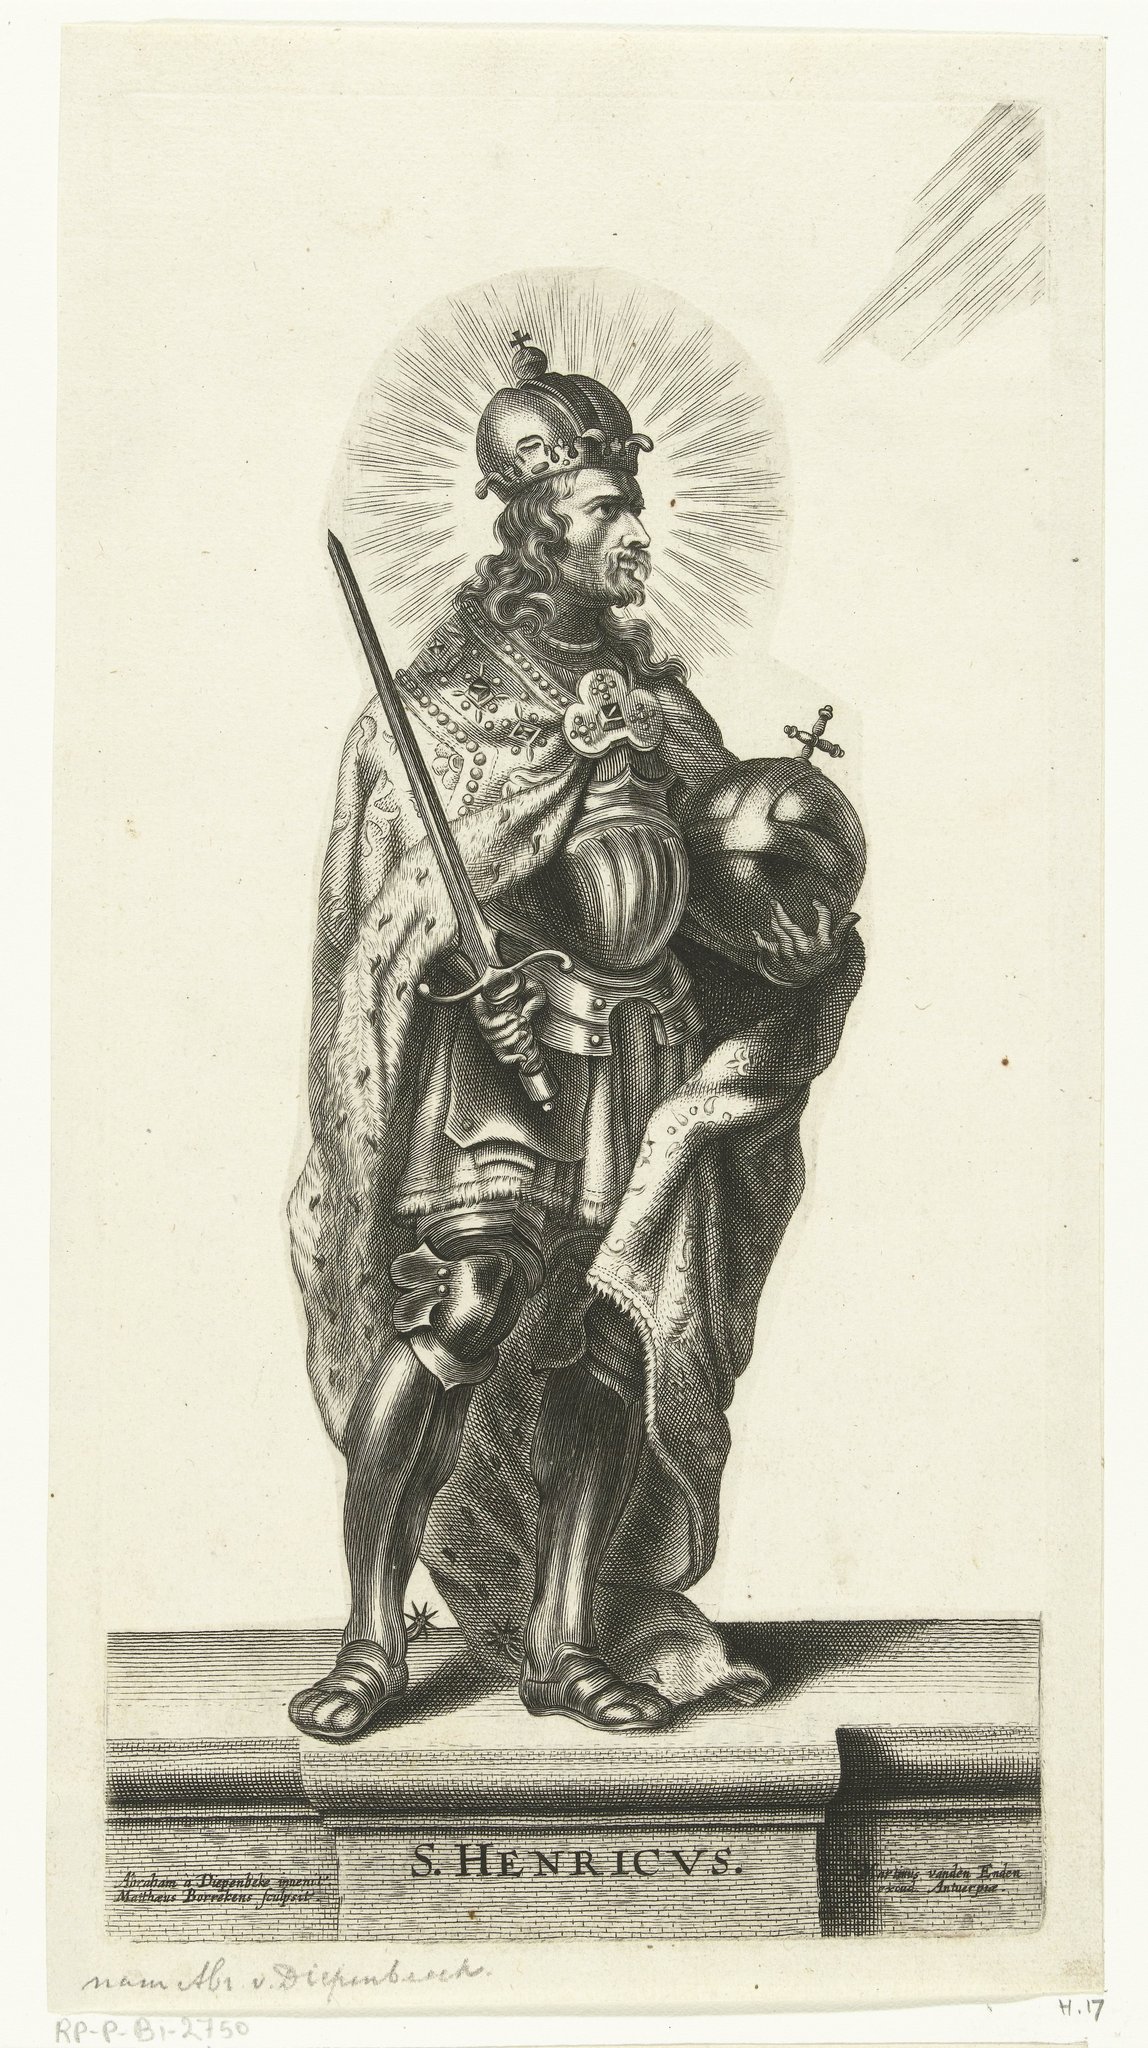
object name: print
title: S. Henricus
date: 1644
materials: paper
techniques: engraving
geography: antwerp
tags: the holy roman emperor henry ii of bamberg; possible attributes: crown, lily, model of church, orb, sceptre, sword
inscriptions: collector's mark: Lugt 240 of 1838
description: De Heilige koning Hendrik II van Duitsland en keizer van het Heilig Roomse rijk. Hendrik draagt een wapenrusting en zijn keizersmantel. Hij draagt tevens de keizerskroon. In zijn linkerhand houdt hij de wereldbol (met kruis) vast, teken van zijn rol als keizer. In zijn rechterhand heeft hij een zwaard, symbool van zijn wereldlijke gezag. Hij heeft een aureool rond zijn hoofd en kijkt naar de rechterbovenhoek van de prent, waar lichtstralen worden getoond.